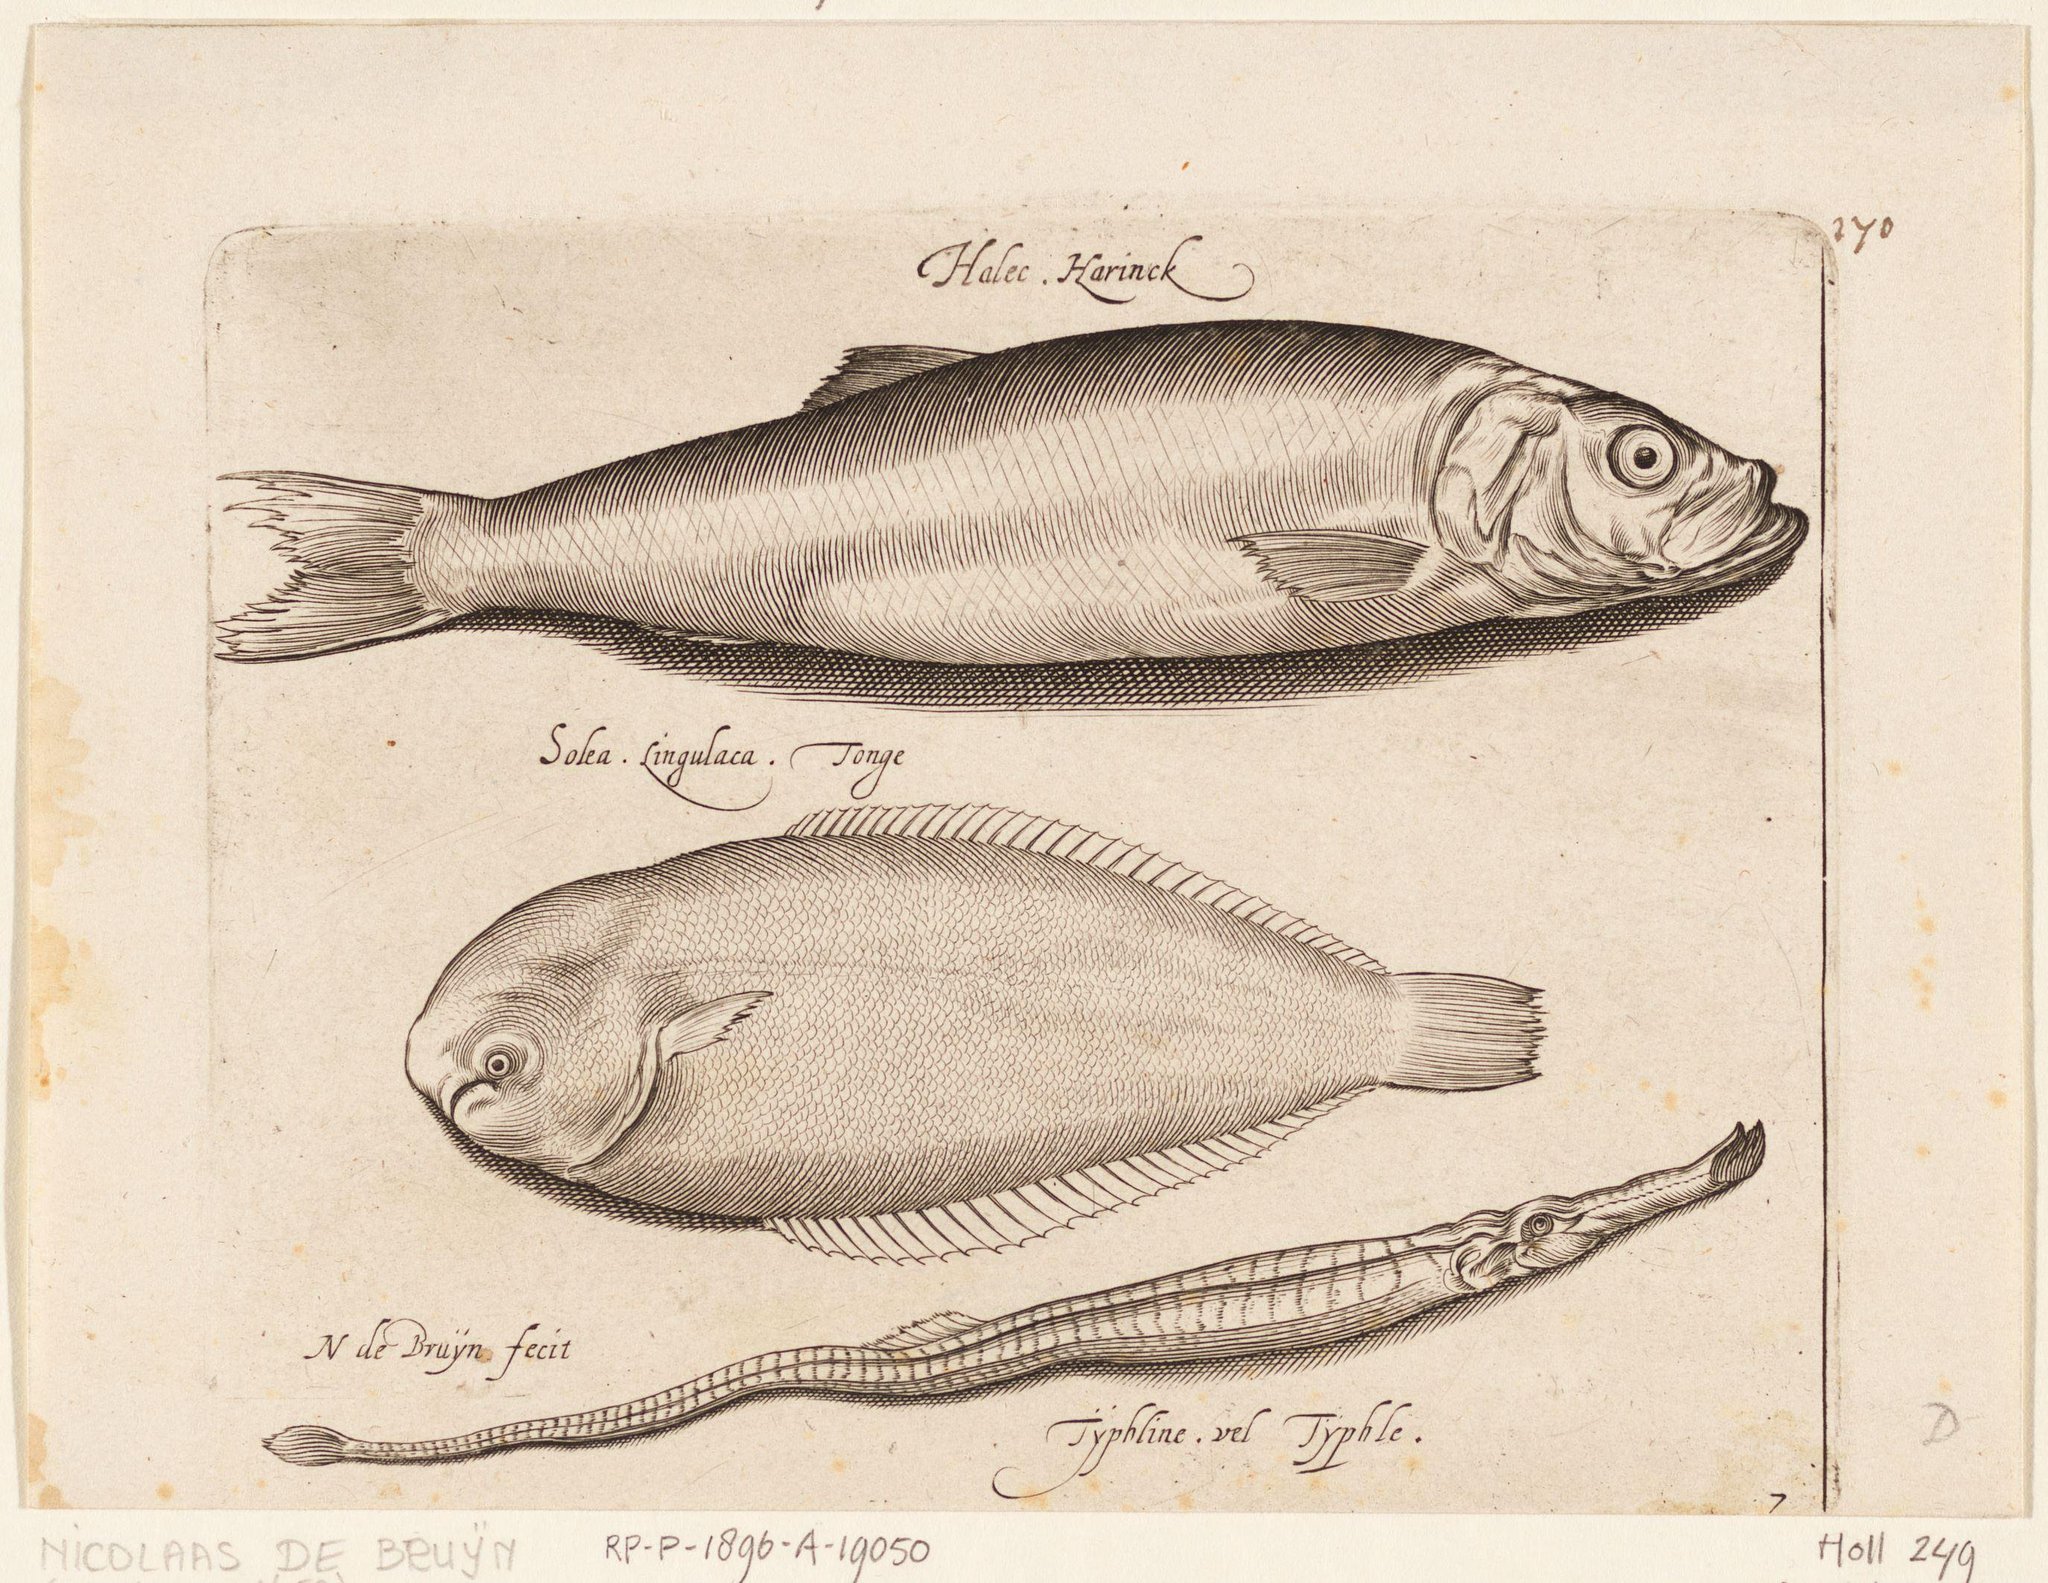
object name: print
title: Libelivs varia Genera piscium complectens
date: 1581-1656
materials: paper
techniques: engraving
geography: netherlands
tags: bony fishes: herring, fishes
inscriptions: collector's mark: Lugt 2228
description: Prent uit serie Libelivs varia Genera piscium complectens van dertien prenten met zoetwatervissen, zeevissen, kikkers, schaaldieren en zeewezens (inclusief titelprent). Vermoedelijk ging een uitgave van Assuerus van Londerseel vooraf aan deze editie van Francoys van Beusekom, zie De Groot 1988, p. 38.